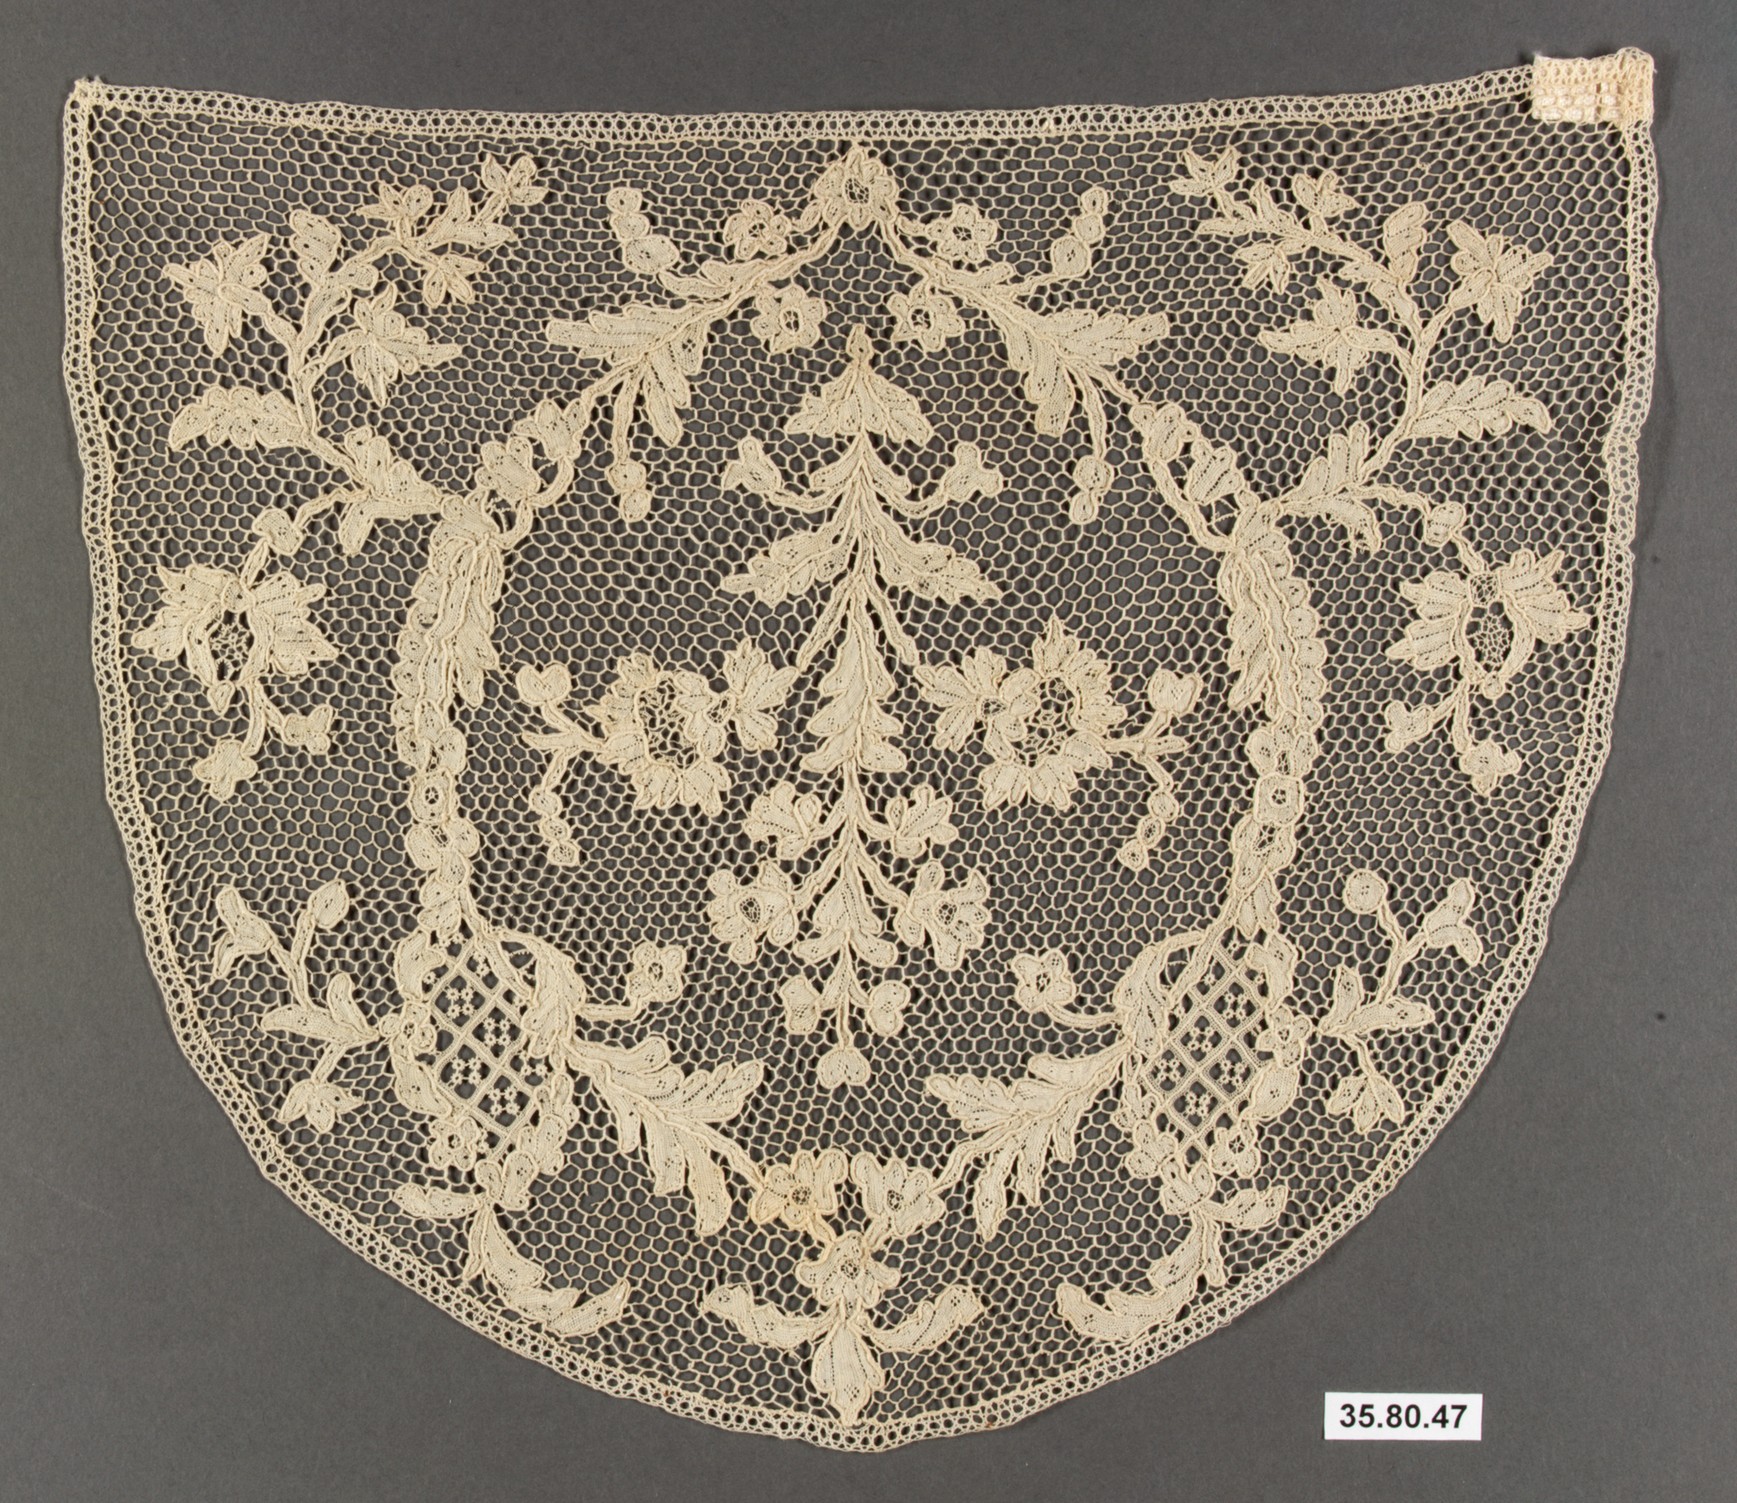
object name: cap crown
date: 1701-1800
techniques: lace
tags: flowers